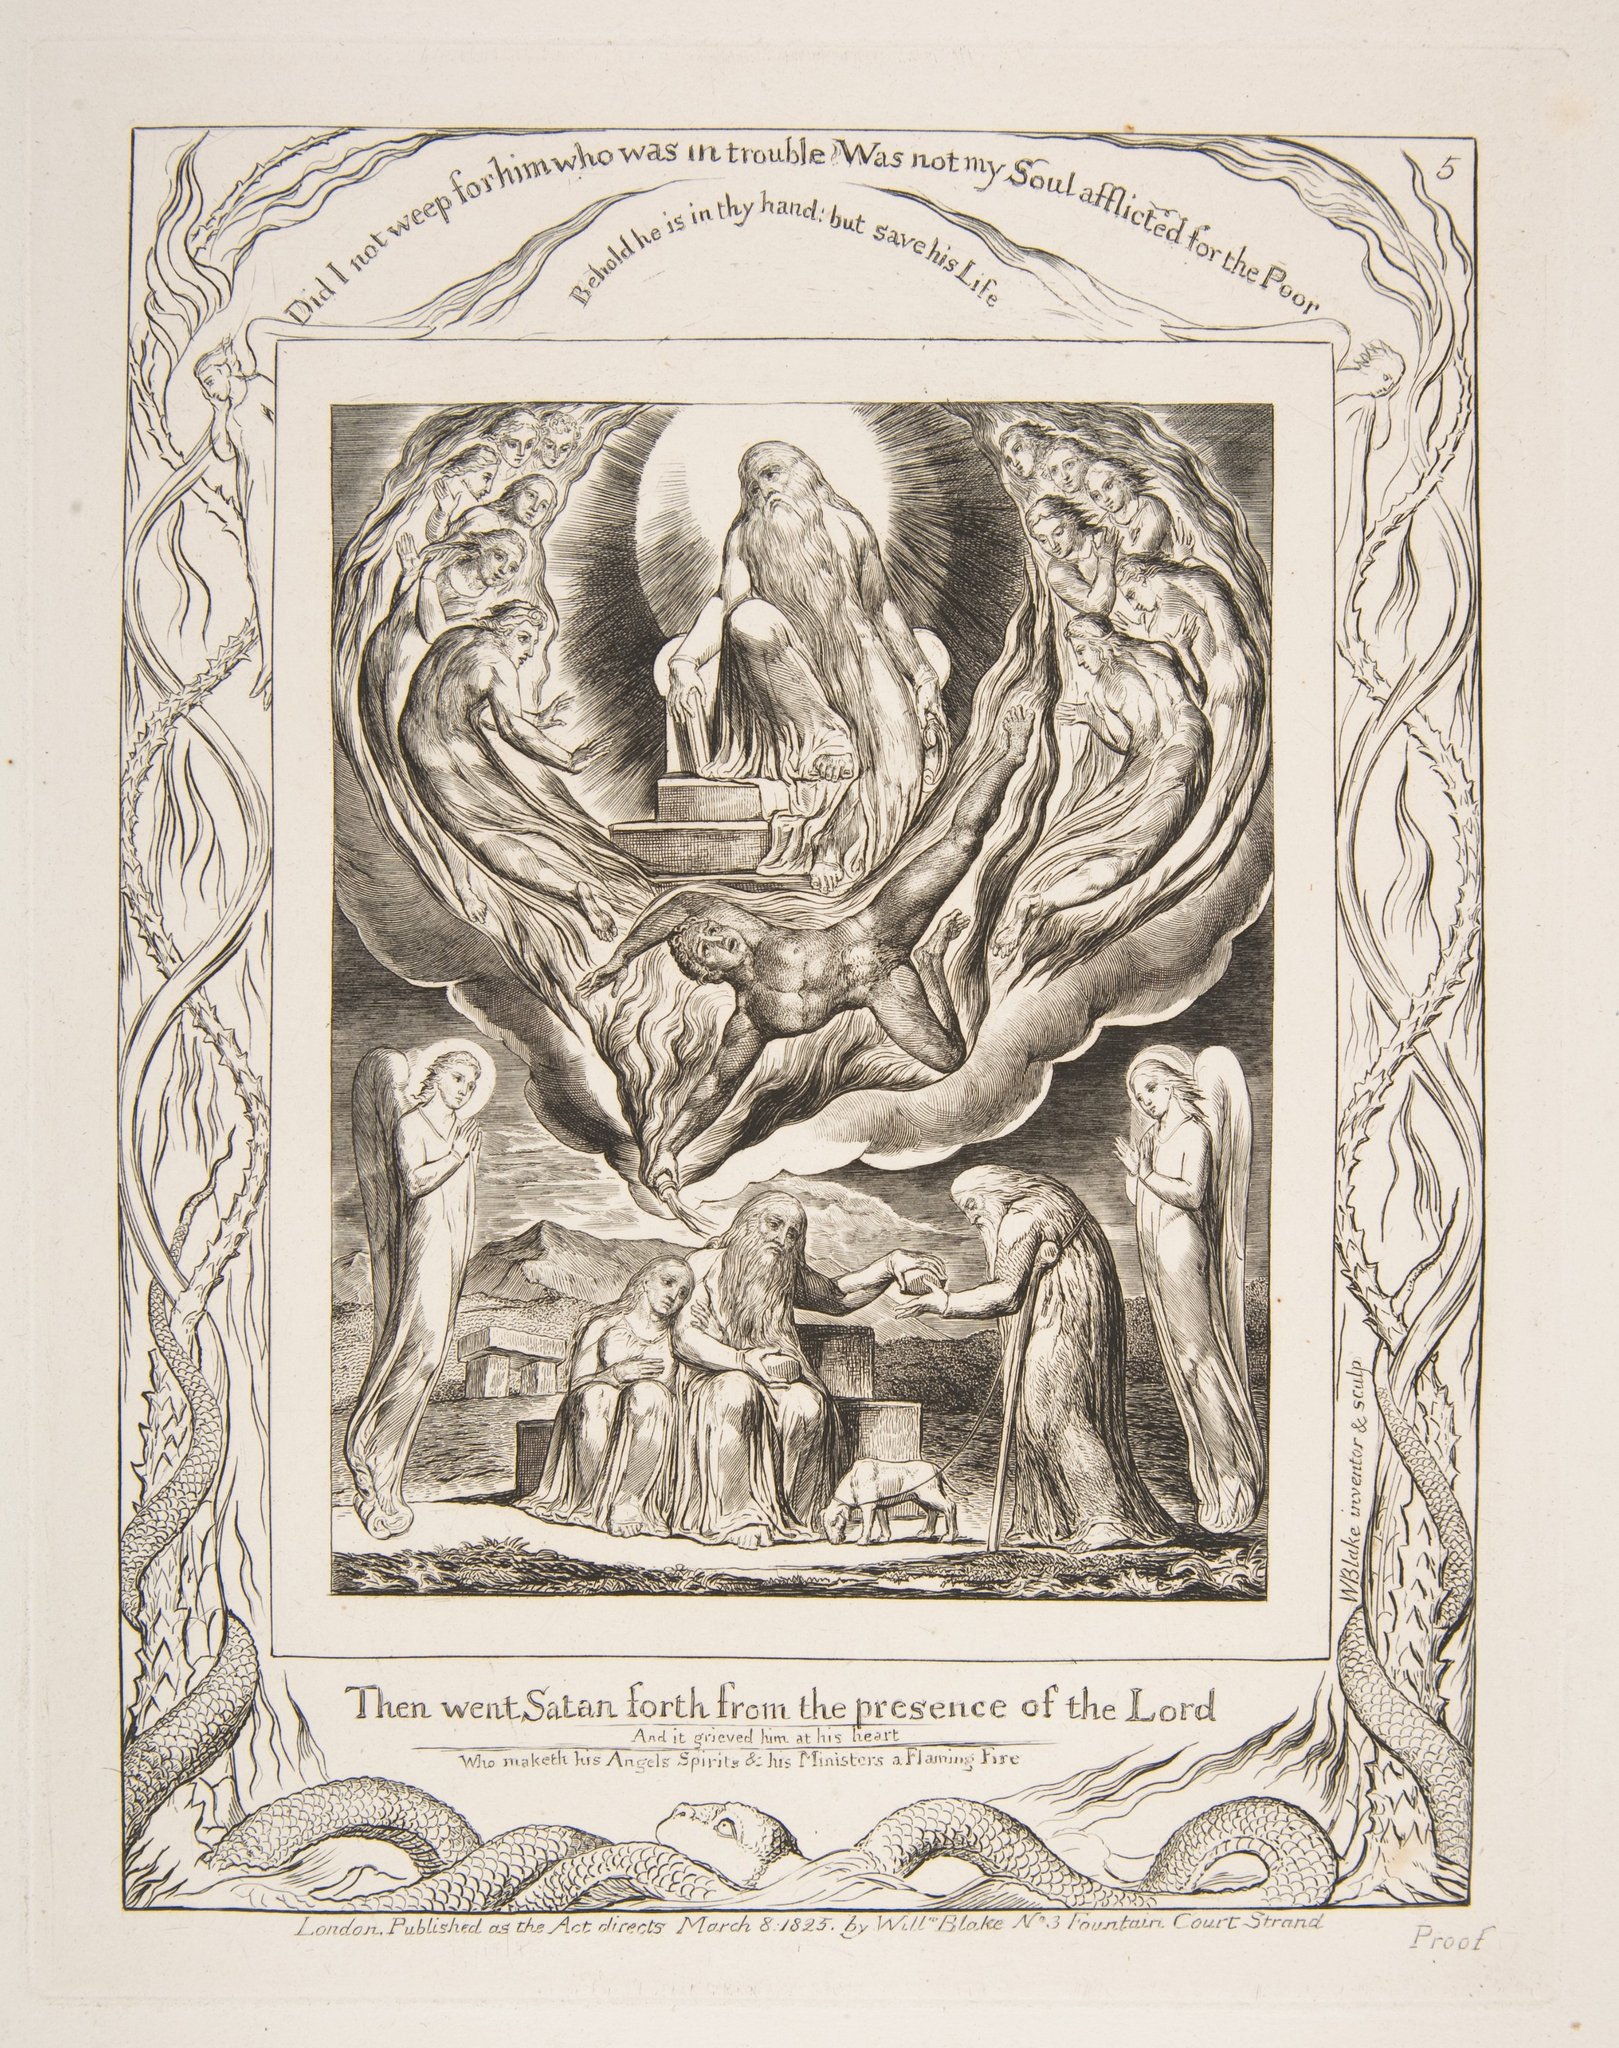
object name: print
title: Satan Going Forth fron the Presence of the Lord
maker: william blake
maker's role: artist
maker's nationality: british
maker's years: 1757-1827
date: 1825-1826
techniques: engraving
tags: animals,men,angels